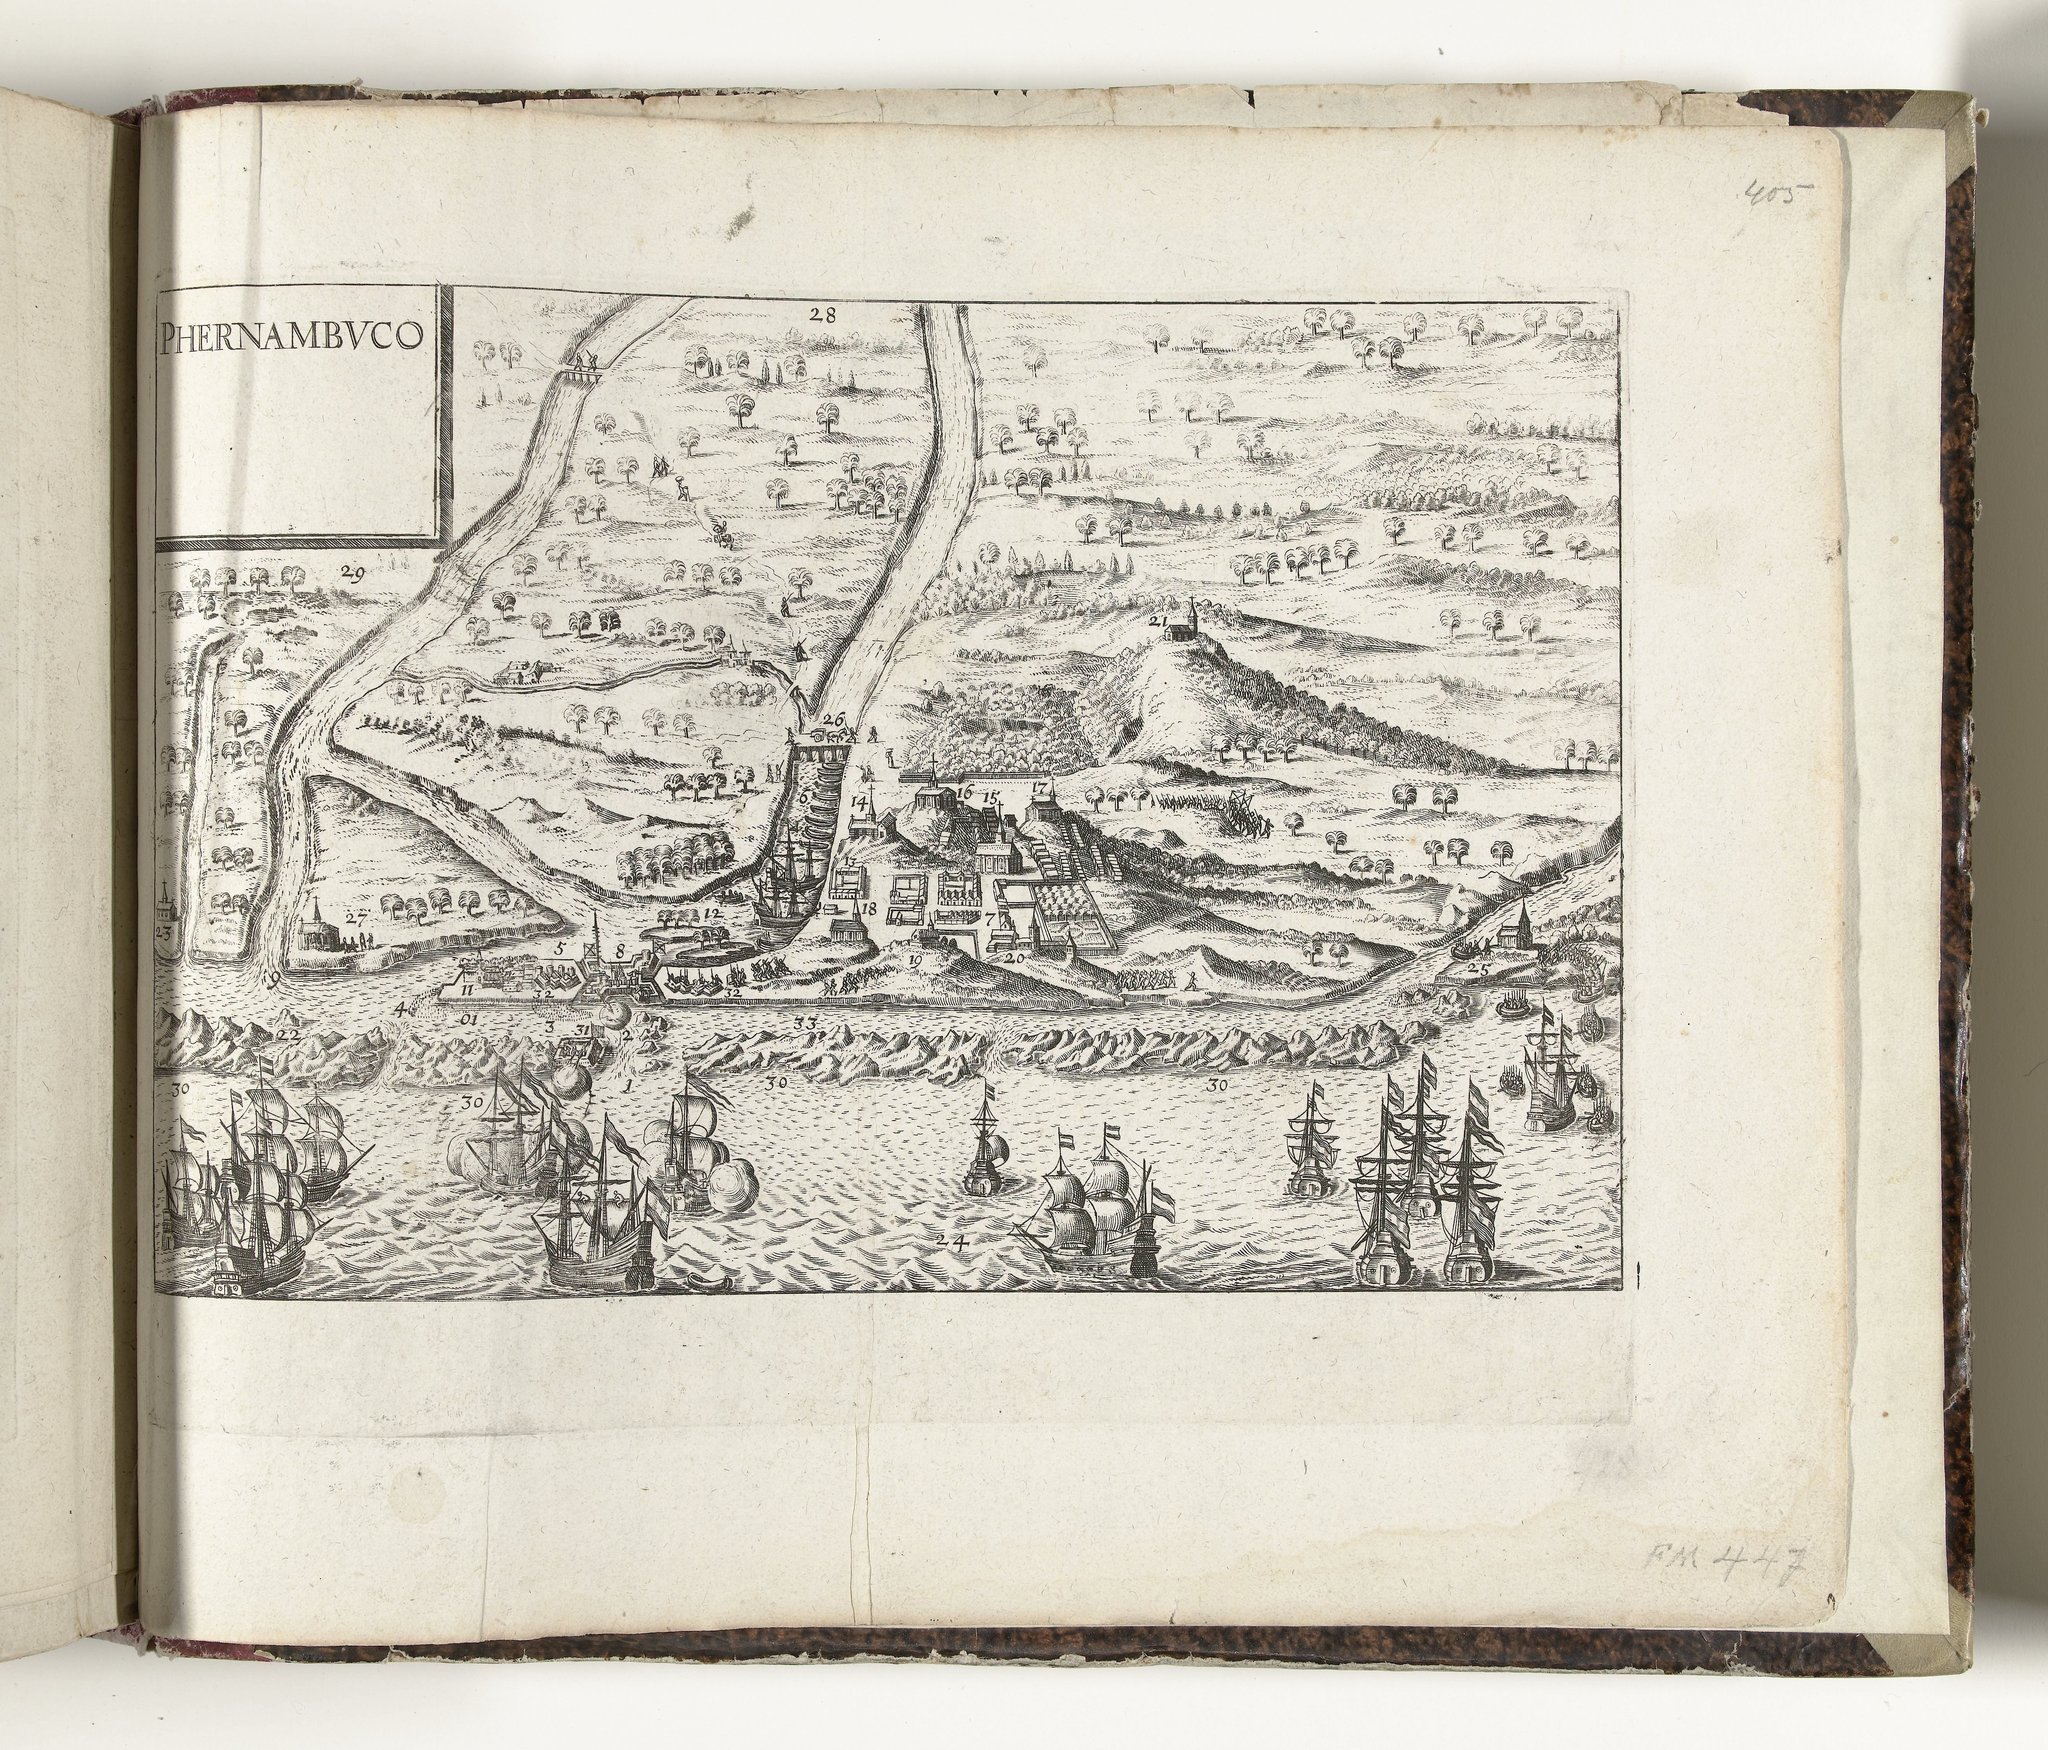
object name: album leaf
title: Gezicht op Pernambuco, 1630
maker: frans hogenberg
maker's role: print maker, publisher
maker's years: 1538-1590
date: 1630-1632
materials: paper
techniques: etching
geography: cologne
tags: pernambuco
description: Gezicht op Pernambuco, 1630. Hollandse schepen op zee voor de kust. Zonder onderschrift en ongenummerd [428]. De prent maakt deel uit van een album.